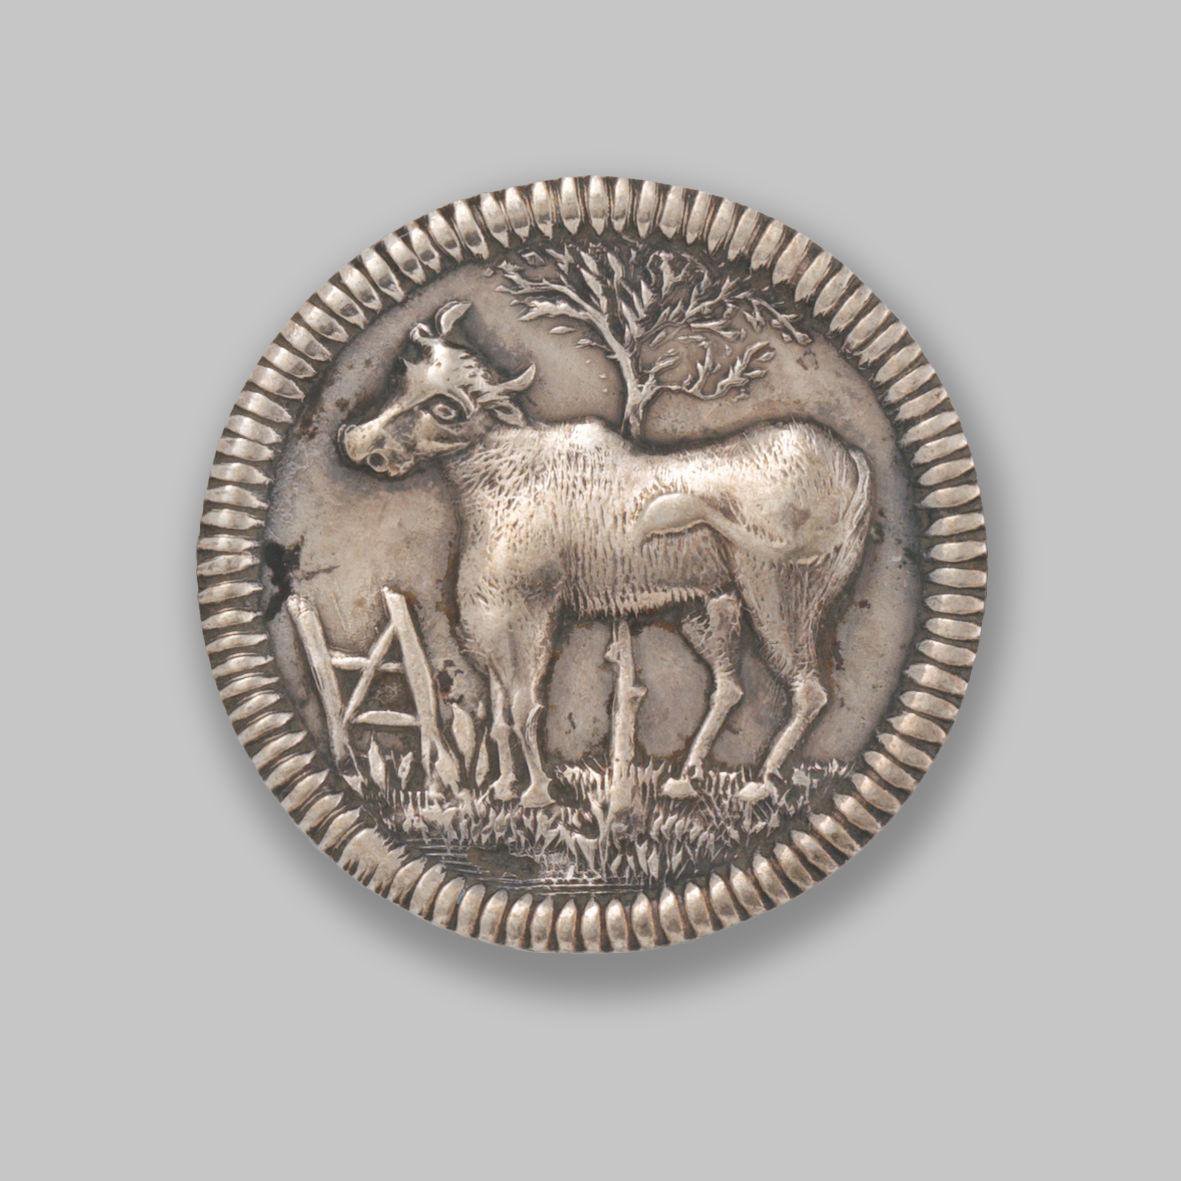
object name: button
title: Knoop met voorstelling van een koe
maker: Anonymous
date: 1850-1900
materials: silver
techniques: casting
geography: netherlands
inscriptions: alloy mark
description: Knoop van gegoten zilver, rond, met op de voorzijde een koe in een weiland omgeven door een geribde rand. Aan de achterzijde is een uit gebogen draad vervaardigd oog bevestigd.